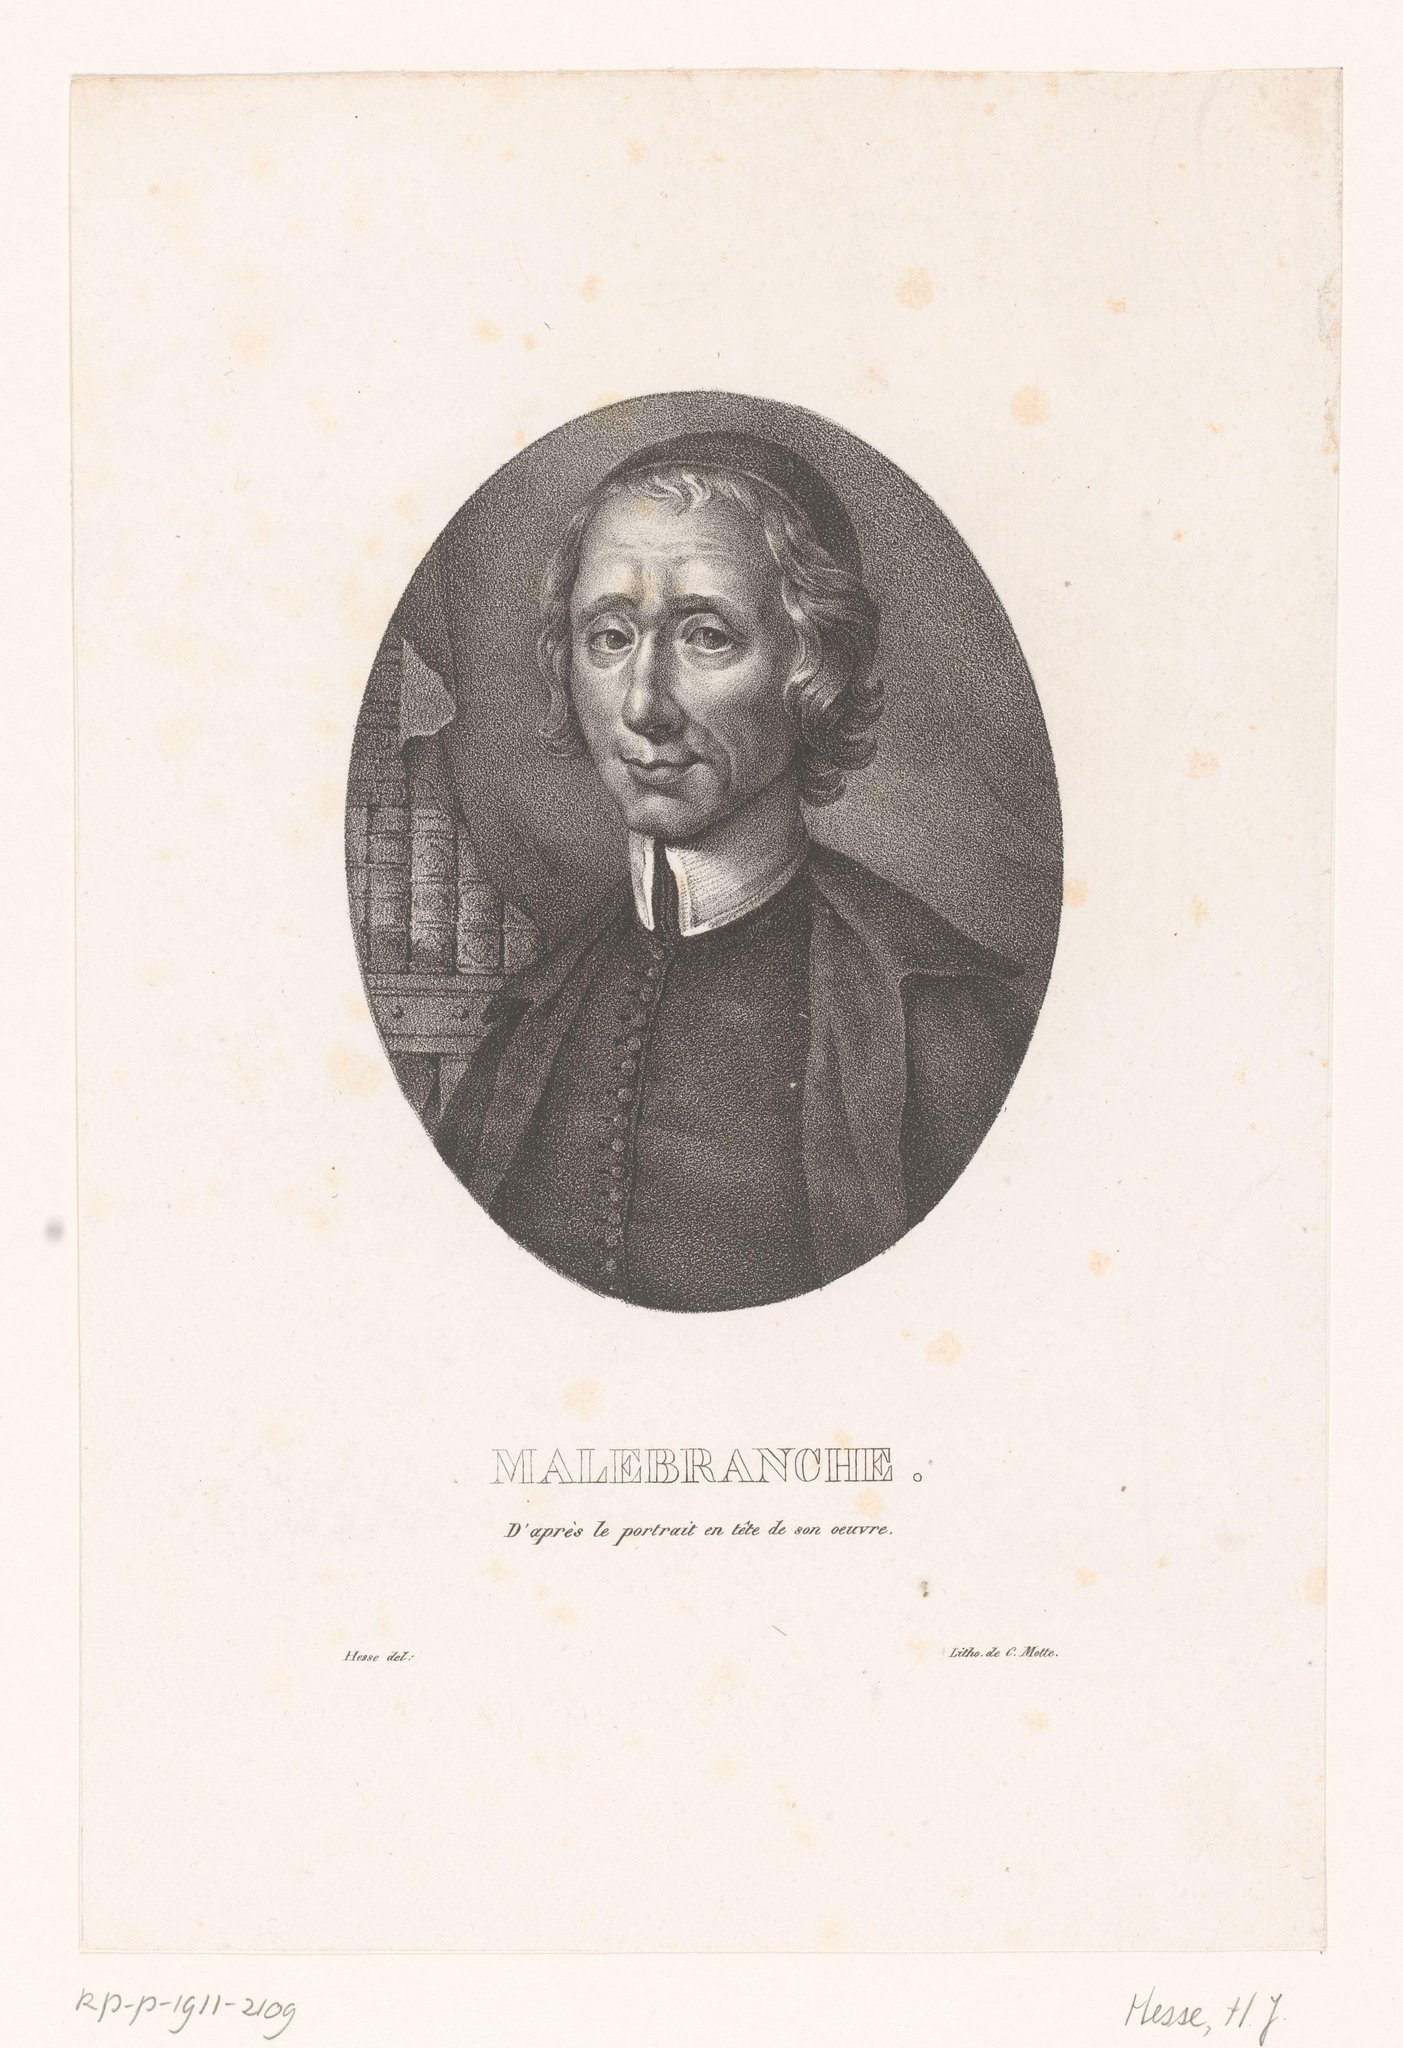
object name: print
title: Portret van Nicolas Malebranche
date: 1823-1826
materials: paper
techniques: lithograph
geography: paris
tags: paris, historical persons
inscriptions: collector's mark: Lugt 2228a